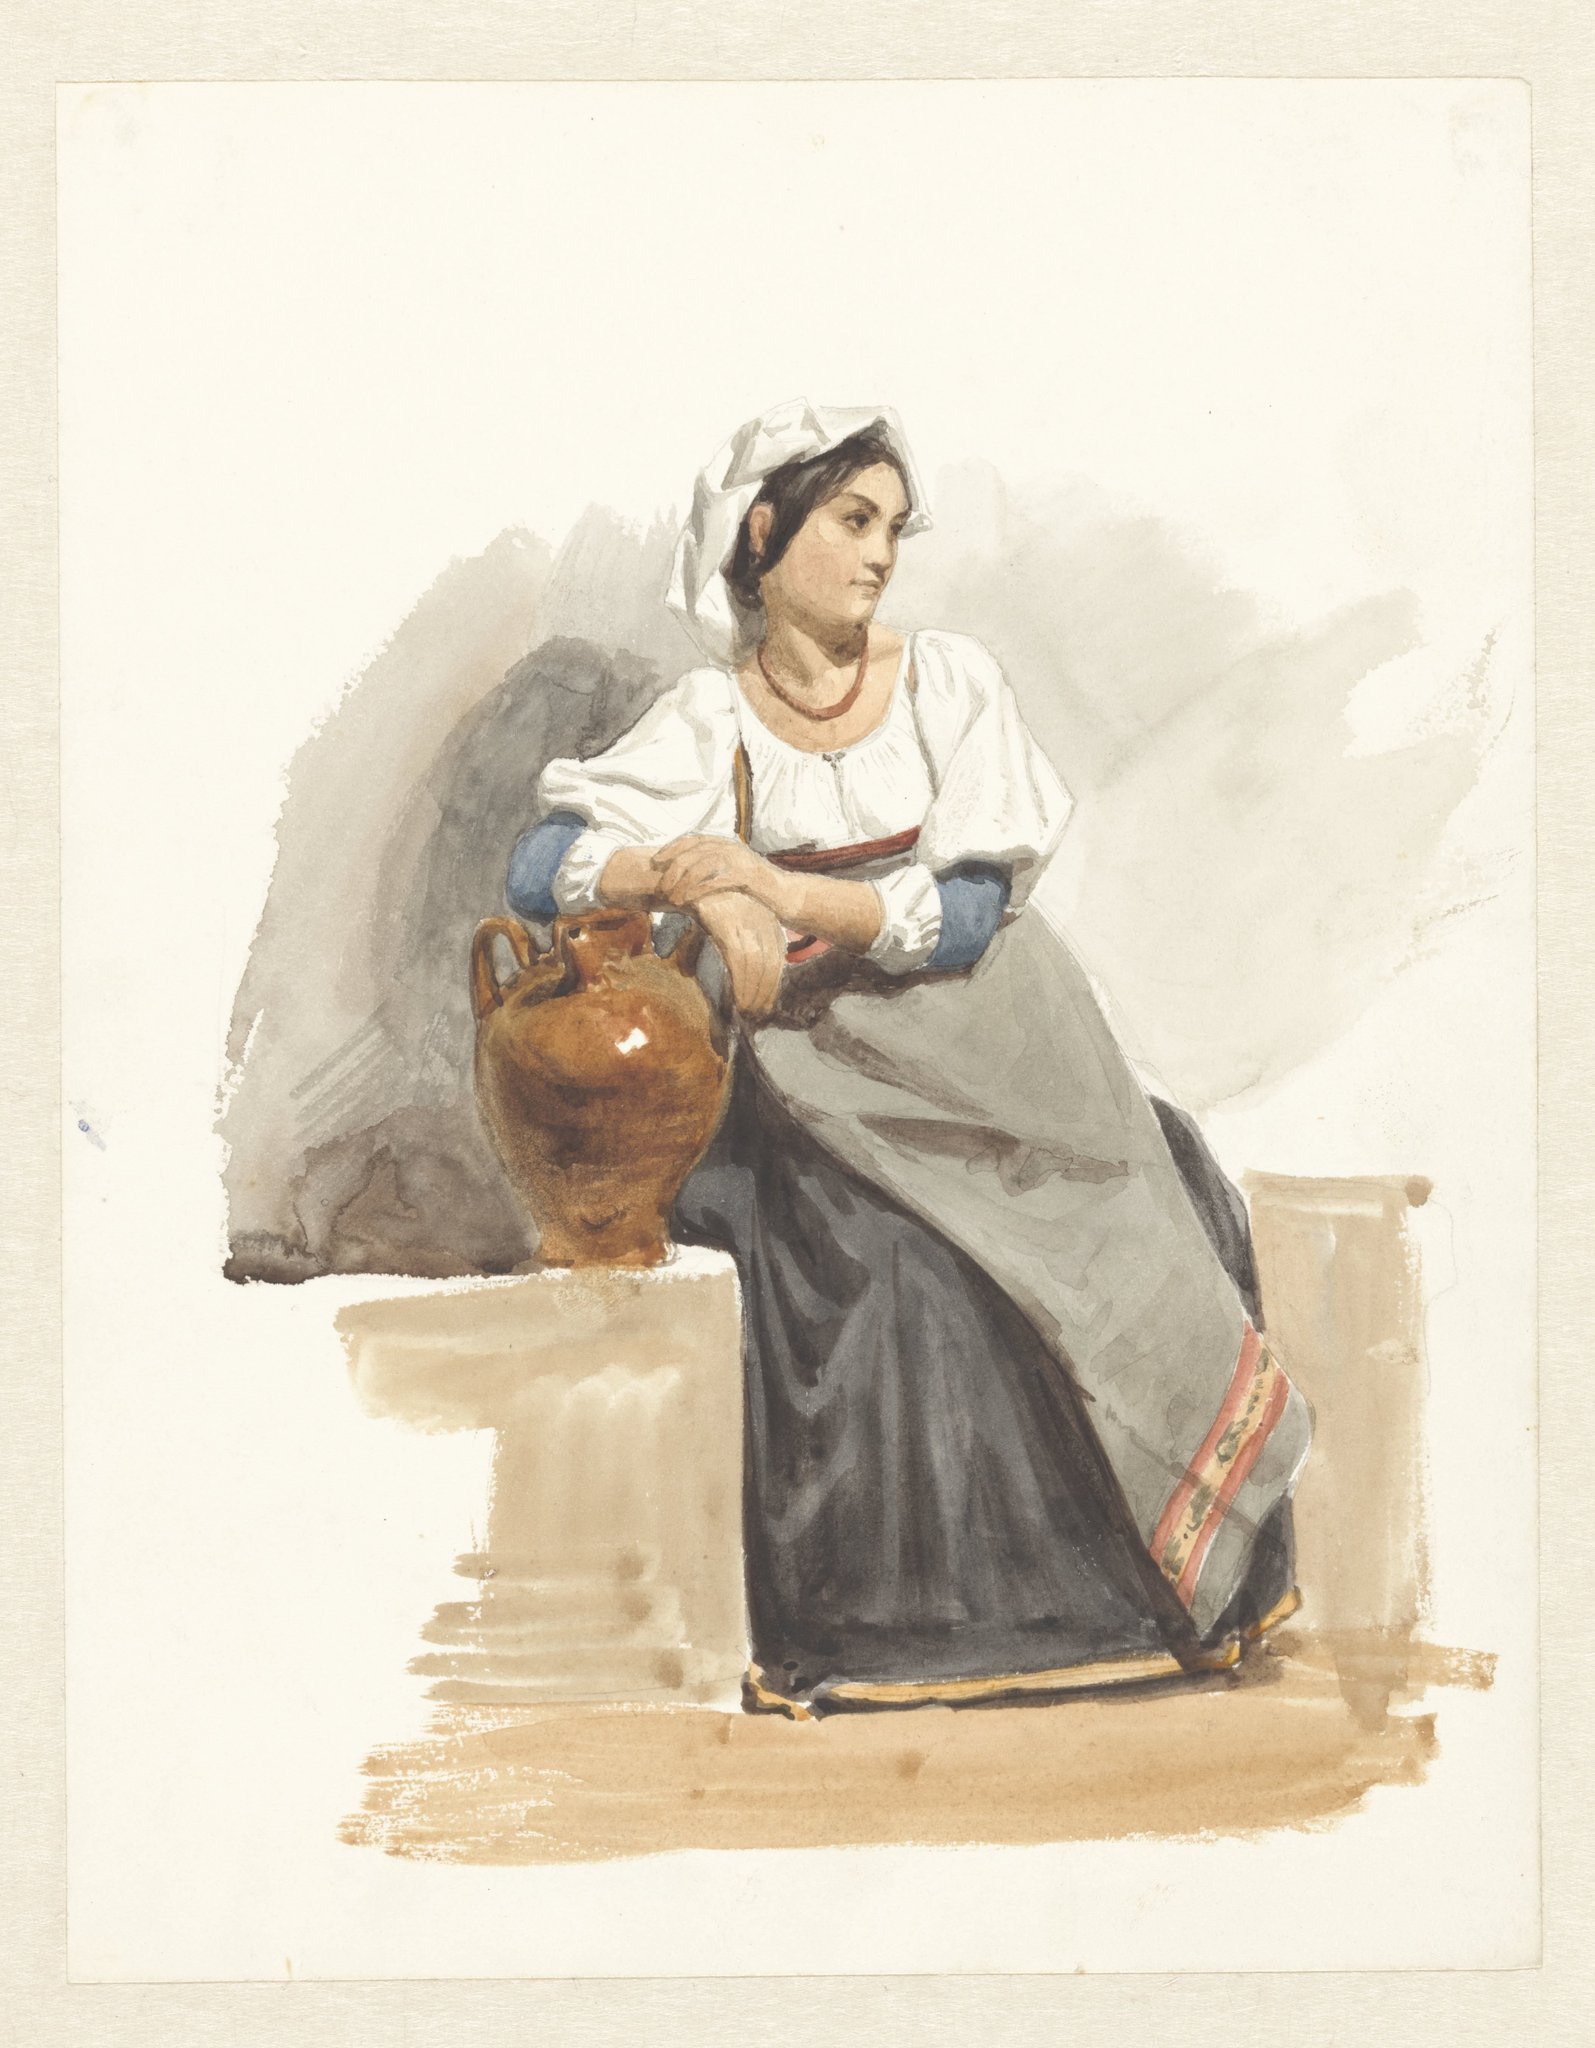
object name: drawing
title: Kostuumstudie van een Italiaans meisje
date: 1825-1873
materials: chalk, paper, watercolor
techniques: brush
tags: folk costume, regional costume, italy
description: Tekening uit een groep tekeningen van landschappen en stadsgezichten in Italië (Rome, Tivoli, Civita Castellana en Pozzuoli).